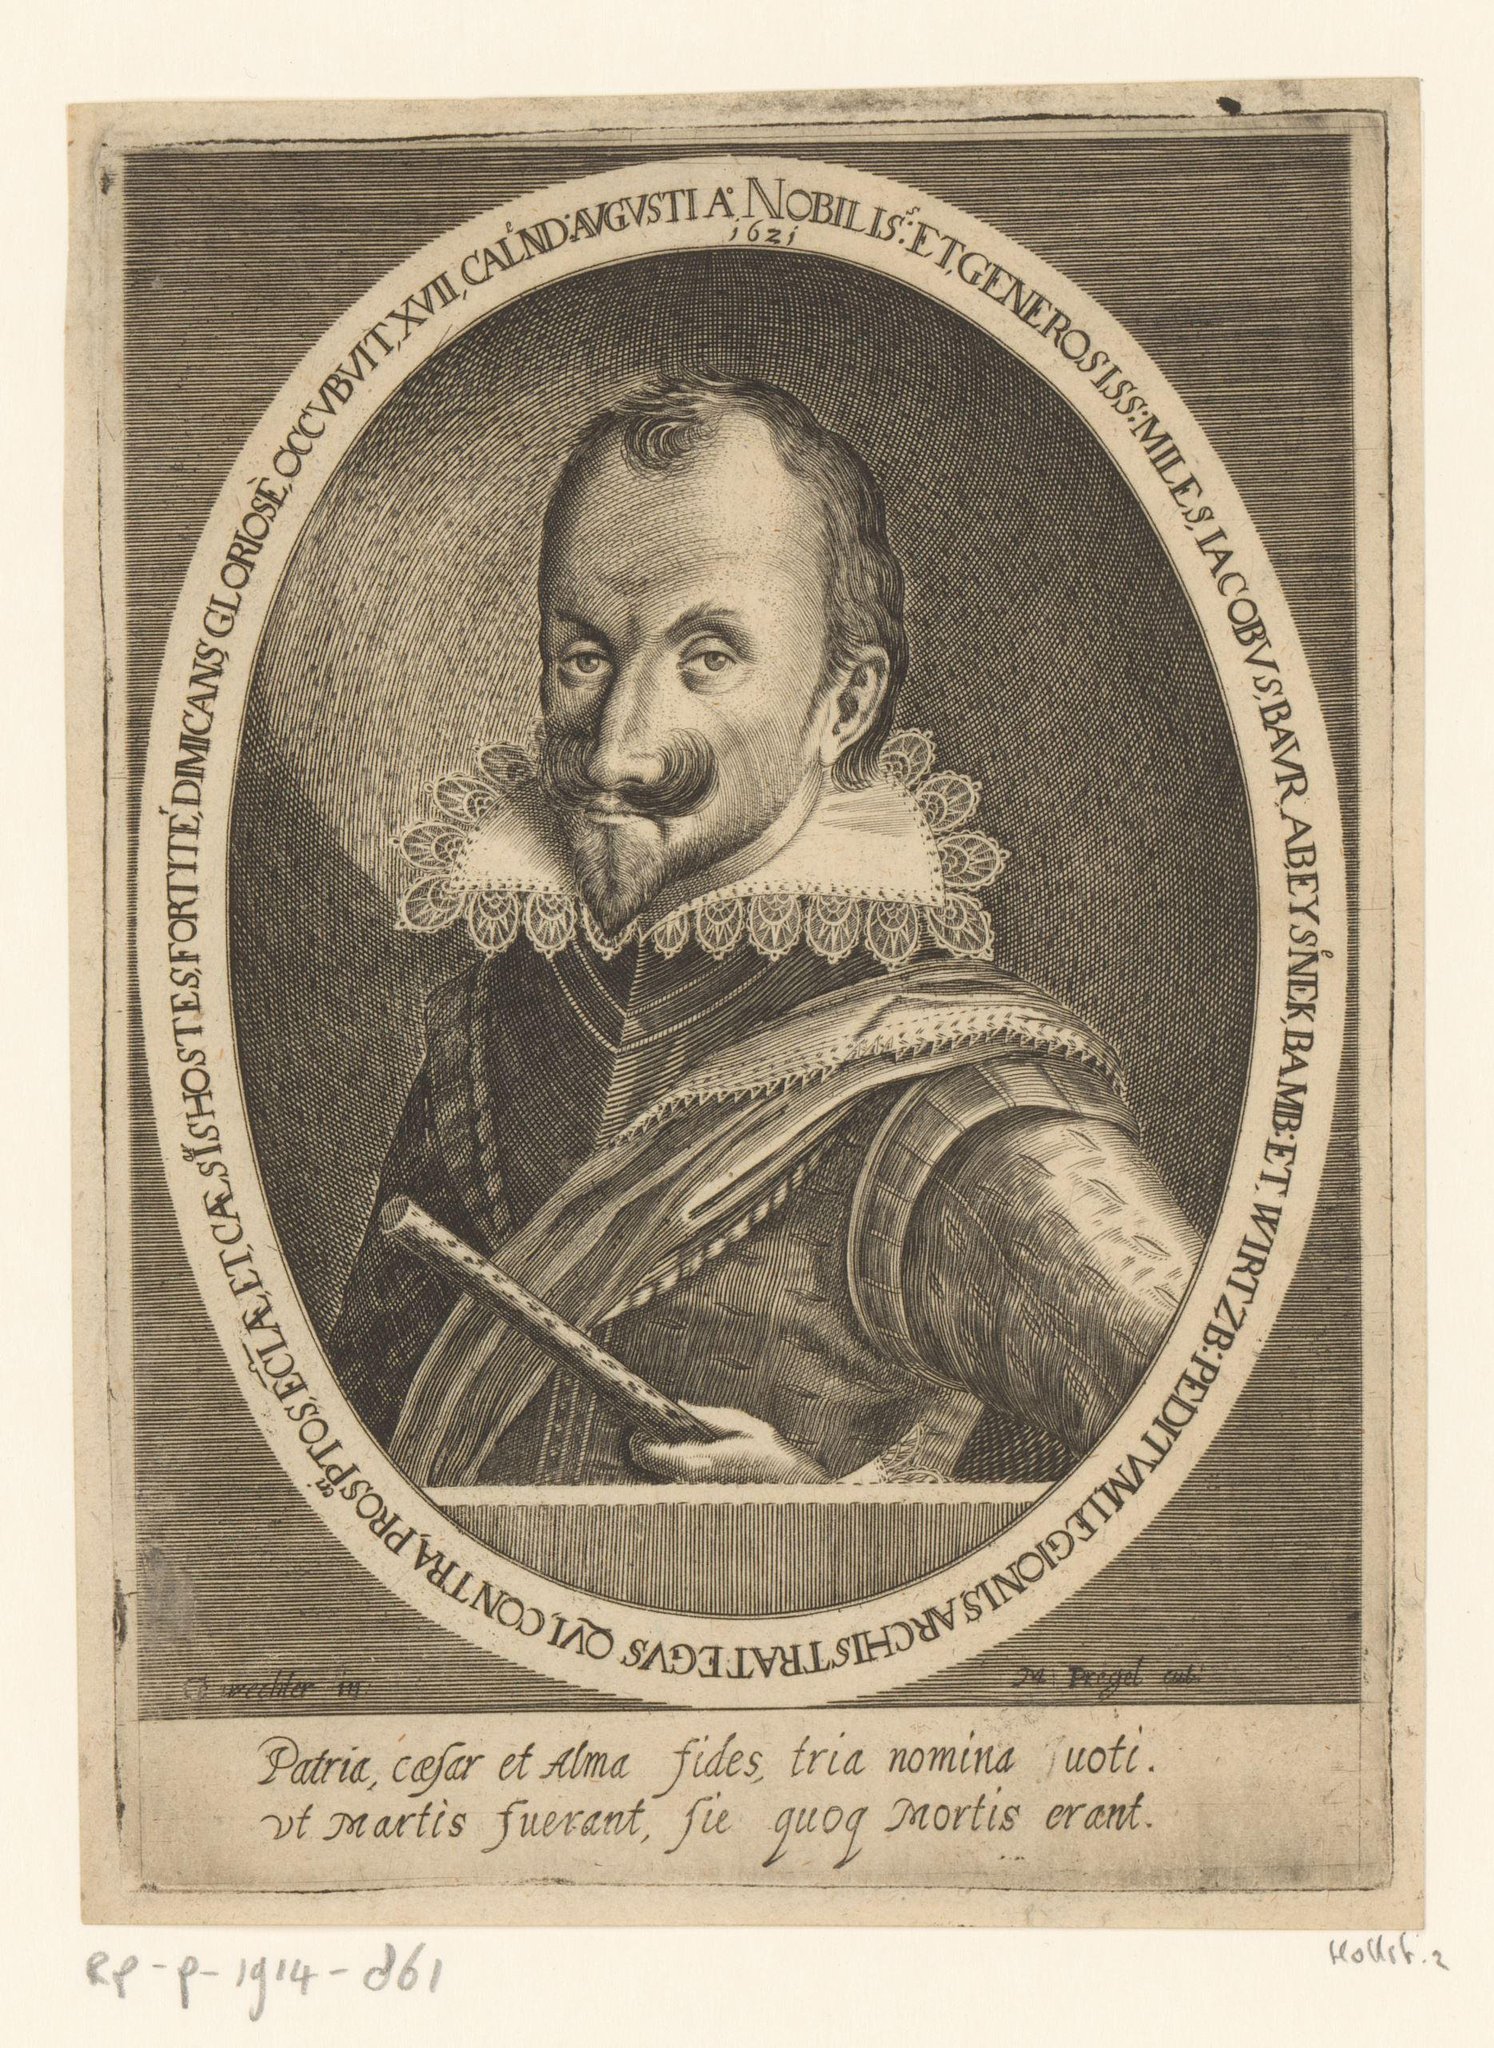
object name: print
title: Portret van Jacob Baur von Eiseneck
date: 1610-1621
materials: paper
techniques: engraving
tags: armour, historical persons, baton of general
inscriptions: collector's mark: Lugt 2228